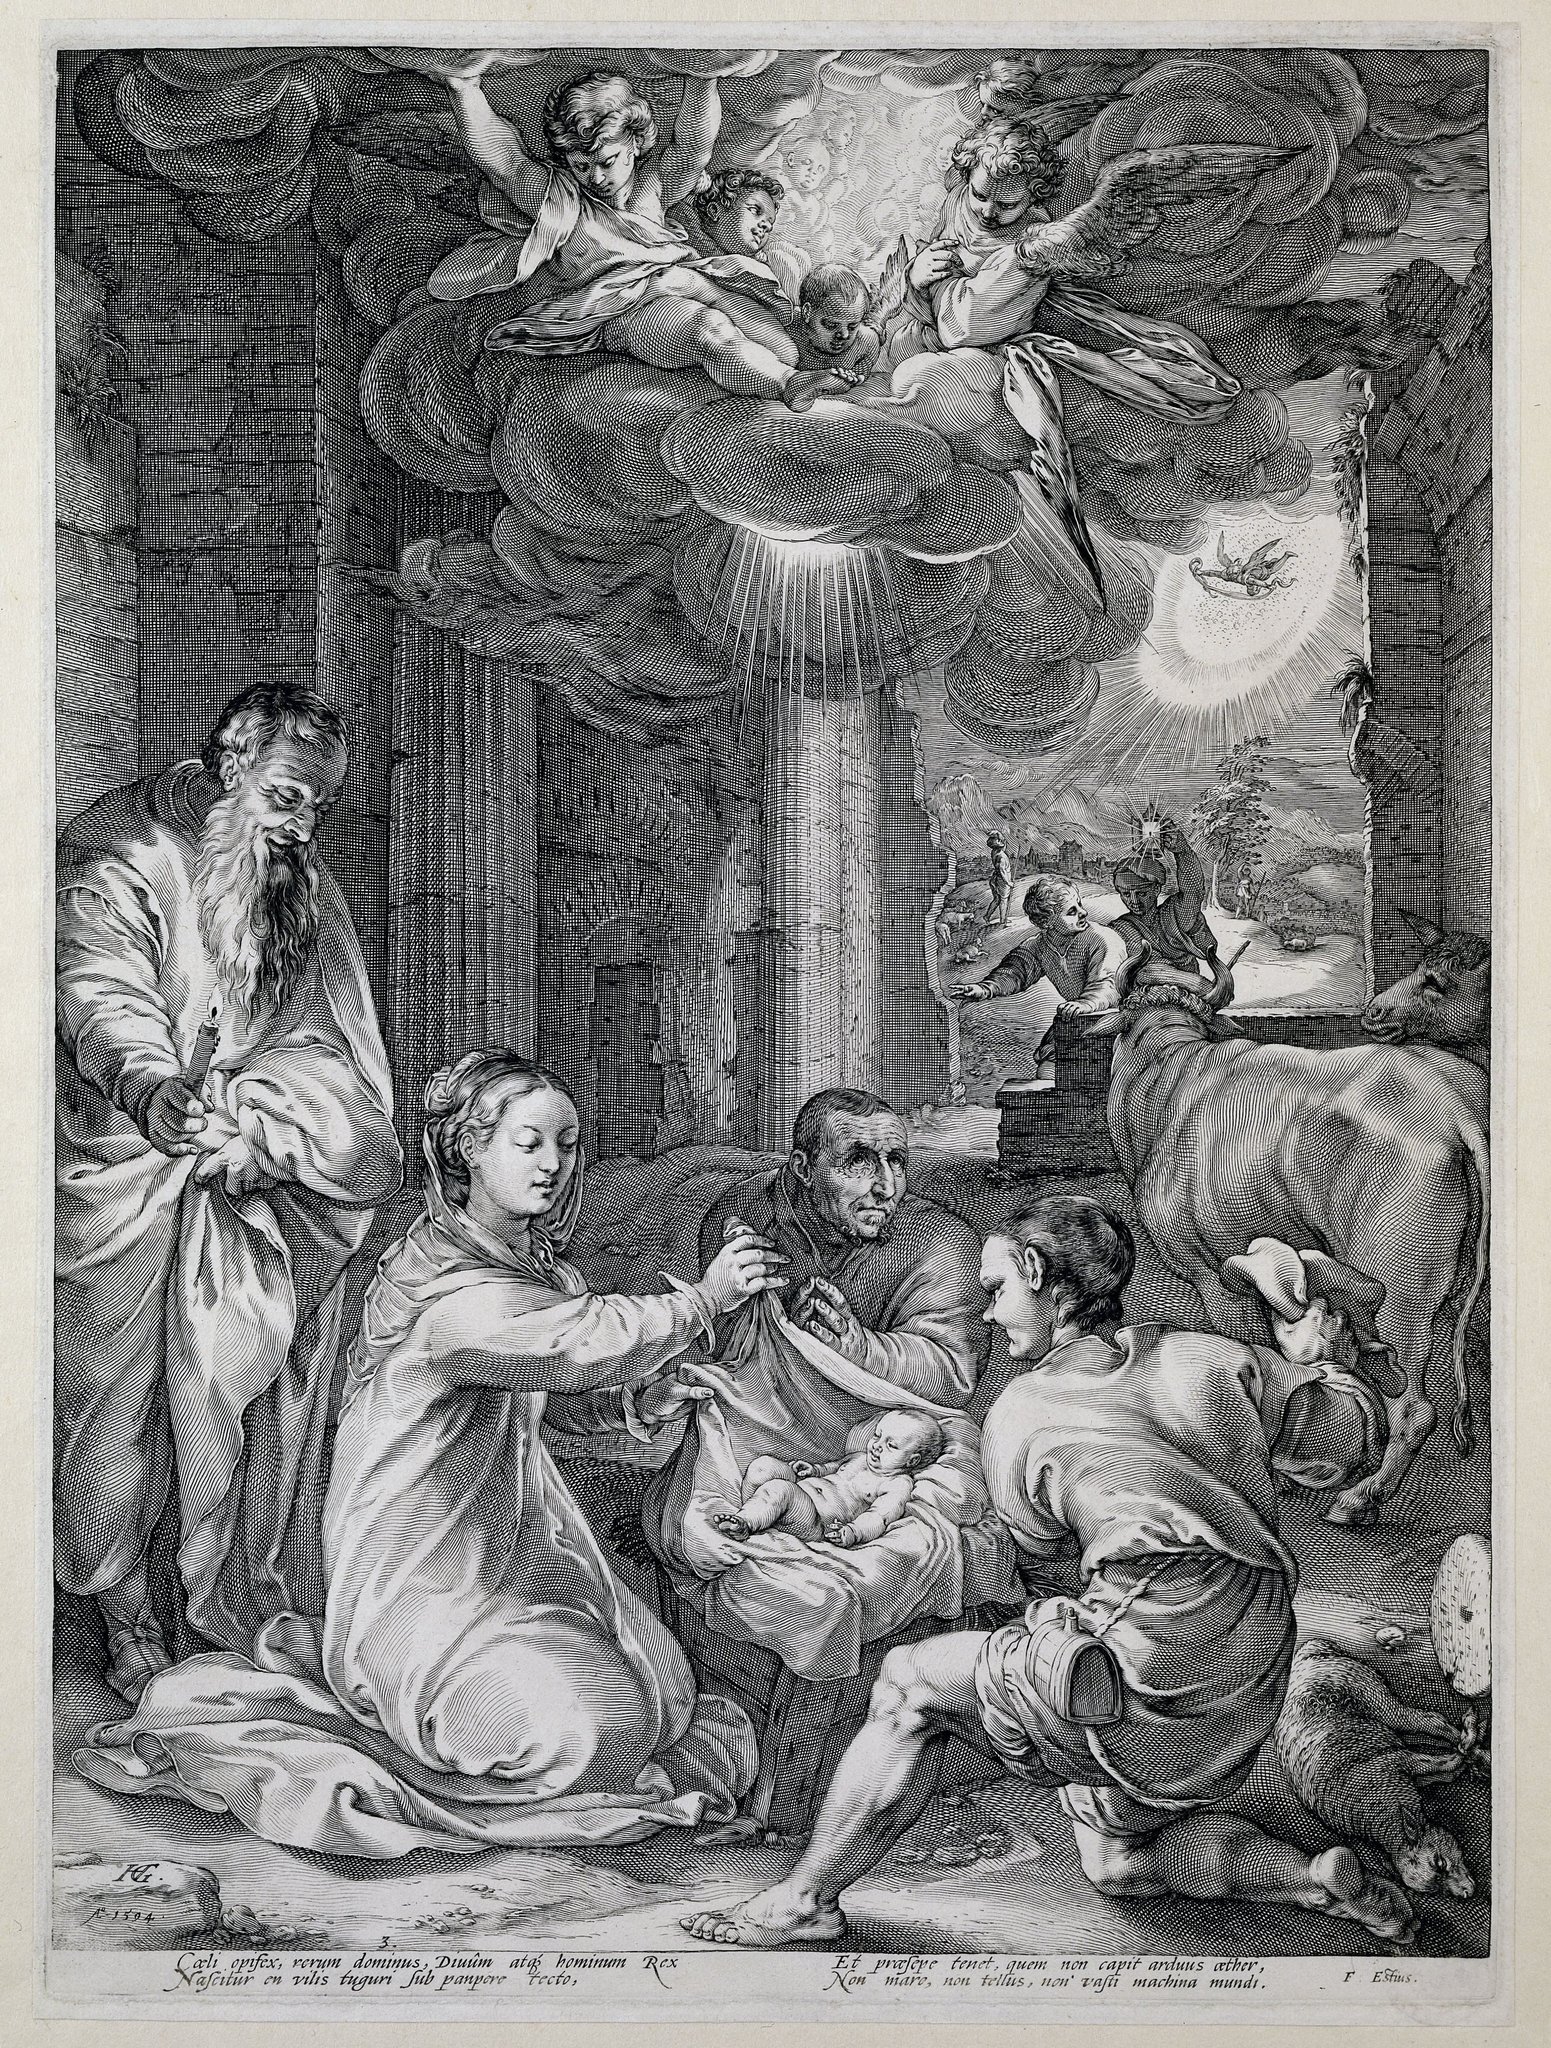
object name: print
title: Het vroege leven van Maria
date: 1594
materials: paper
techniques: engraving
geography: haarlem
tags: adoration of the christ-child by the shepherds; mary and joseph present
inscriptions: date: ‘Ao 1594.’, signature: ‘HG.’, caption: ‘Coeli opifex, rerum dominus ... machina mundi’, collector's mark: Lugt 240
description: Maria en Jozef tonen, gezeten in/bij een ruïne, hun pasgeboren kind aan twee herders. Op de achtergrond de verkondiging aan de herders door een engel. Onder de voorstelling vier Latijnse versregels. Deze prent is onderdeel van een serie van zes prenten met scènes uit het vroege leven van Maria. Die worden de 'Meesterstukken' genoemd, omdat Goltzius er het werk van verschillende illustere voorgangers in heeft nagebootst.